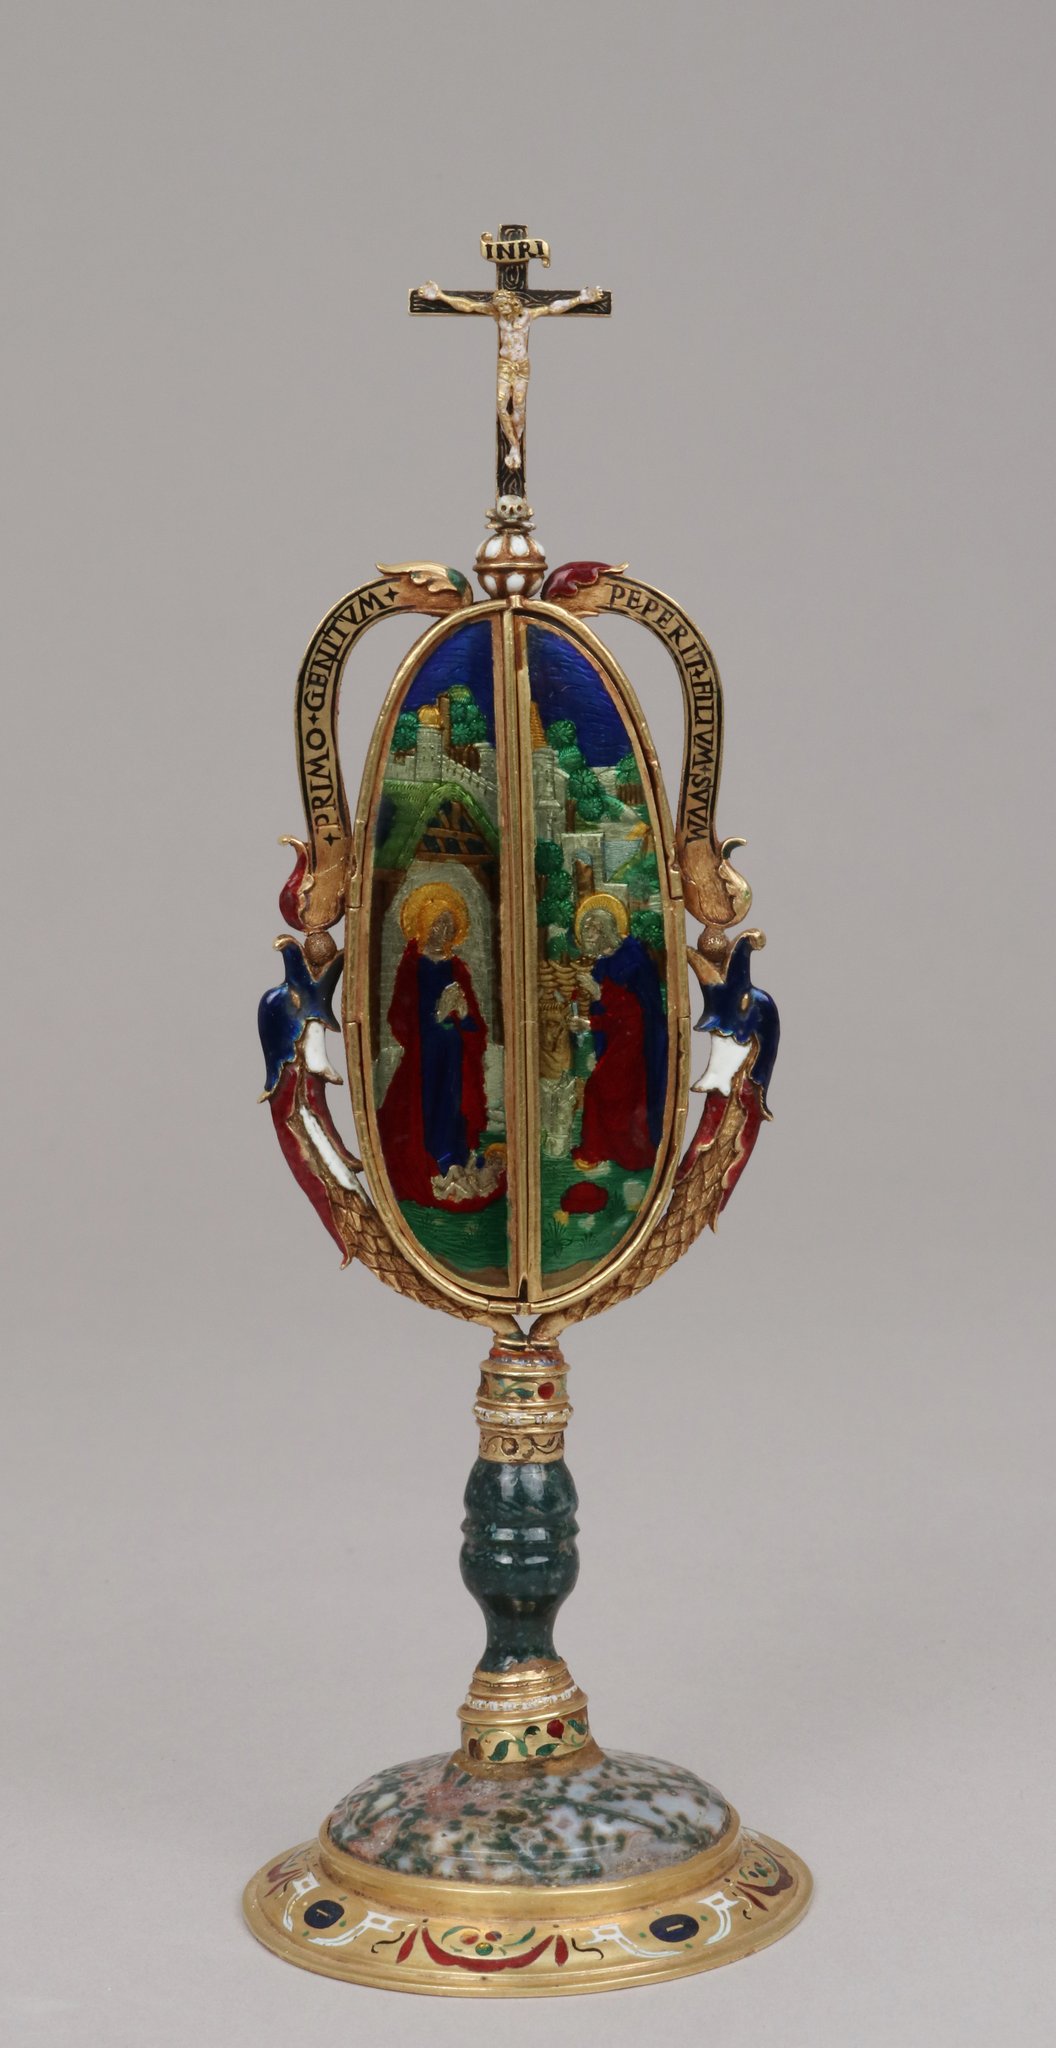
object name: triptych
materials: enamel, gold, jasper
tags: christ,madonna and child,crucifixion